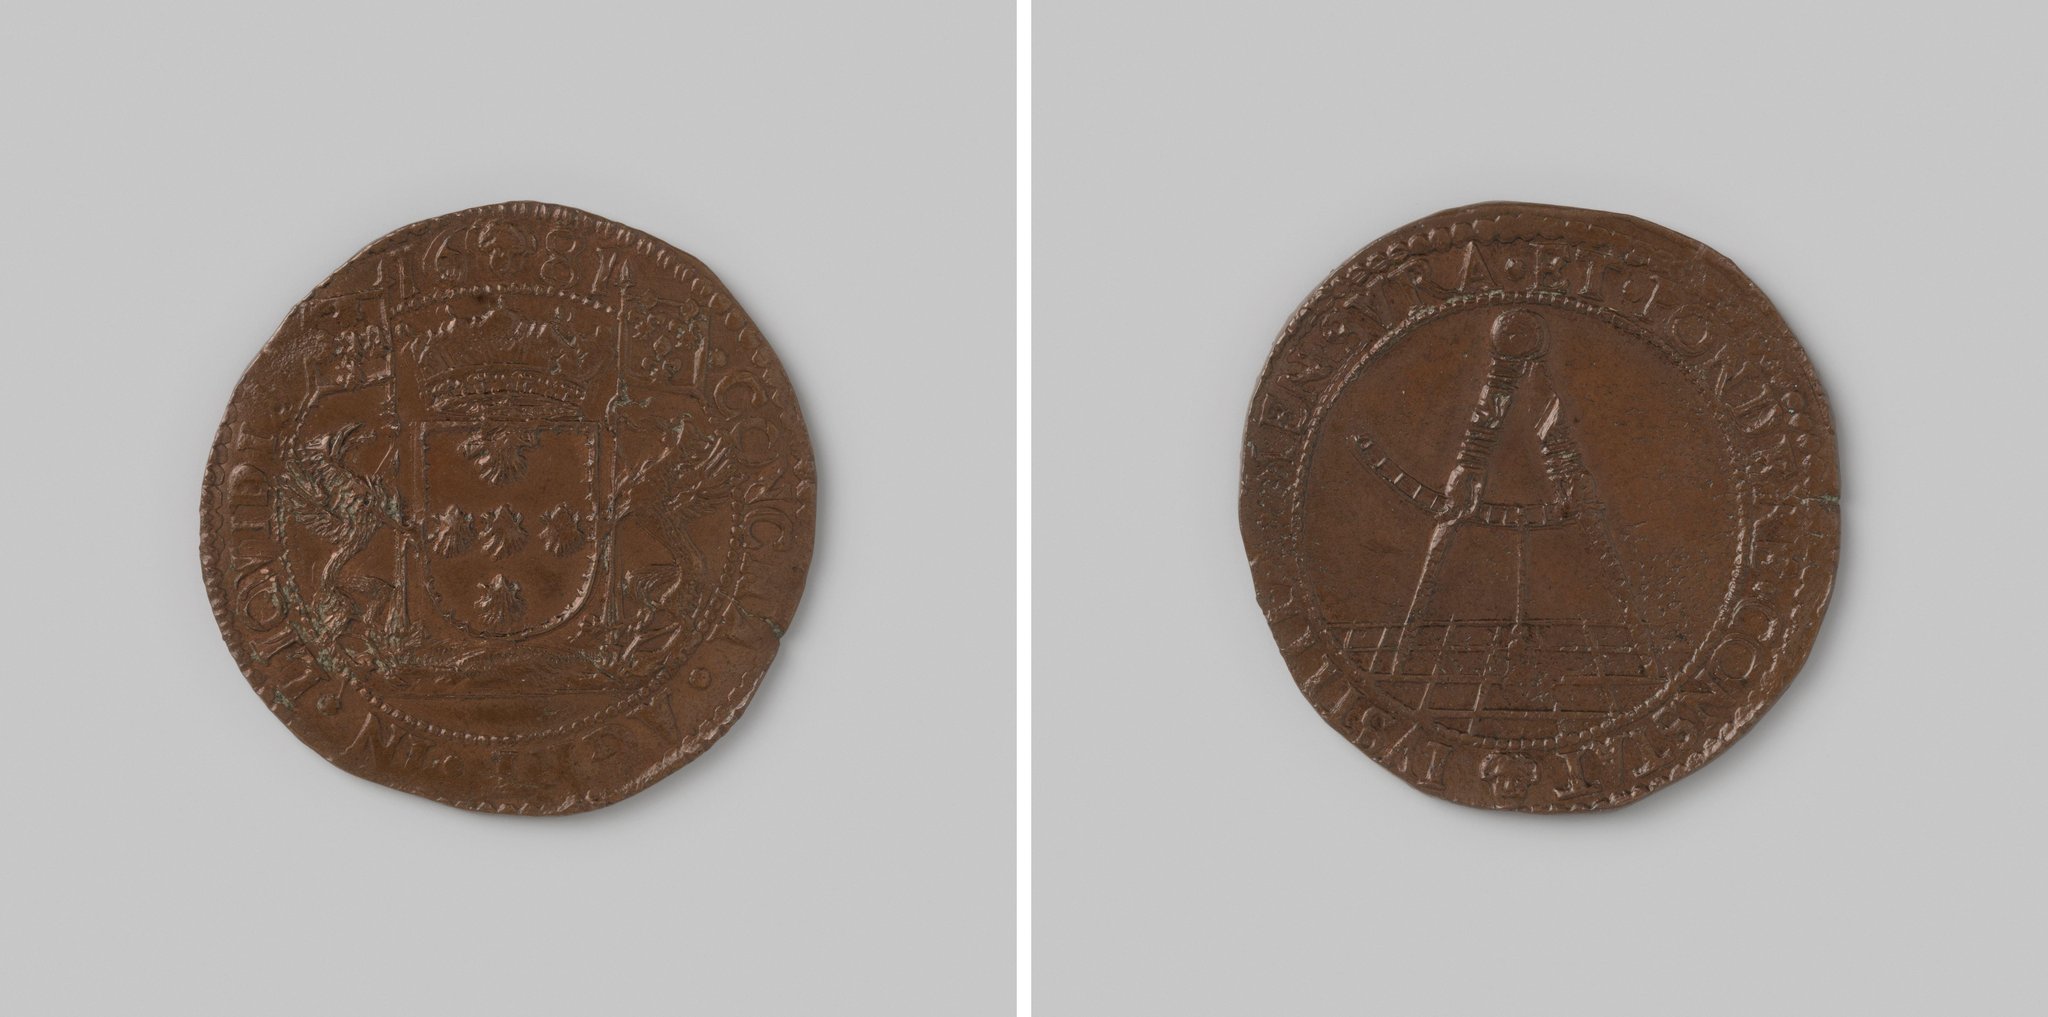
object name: history medal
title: Rekenpenning uit Brussel voor Van der Noot 1681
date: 1681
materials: copper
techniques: striking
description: Koperen penning, op de voorzijde het gekroonde wapenschild van Van der Noot, met griffioenen met vaandels als dragers, met omschrift, op de keerzijde een passer met schietlood boven een kaart, met omschrift.